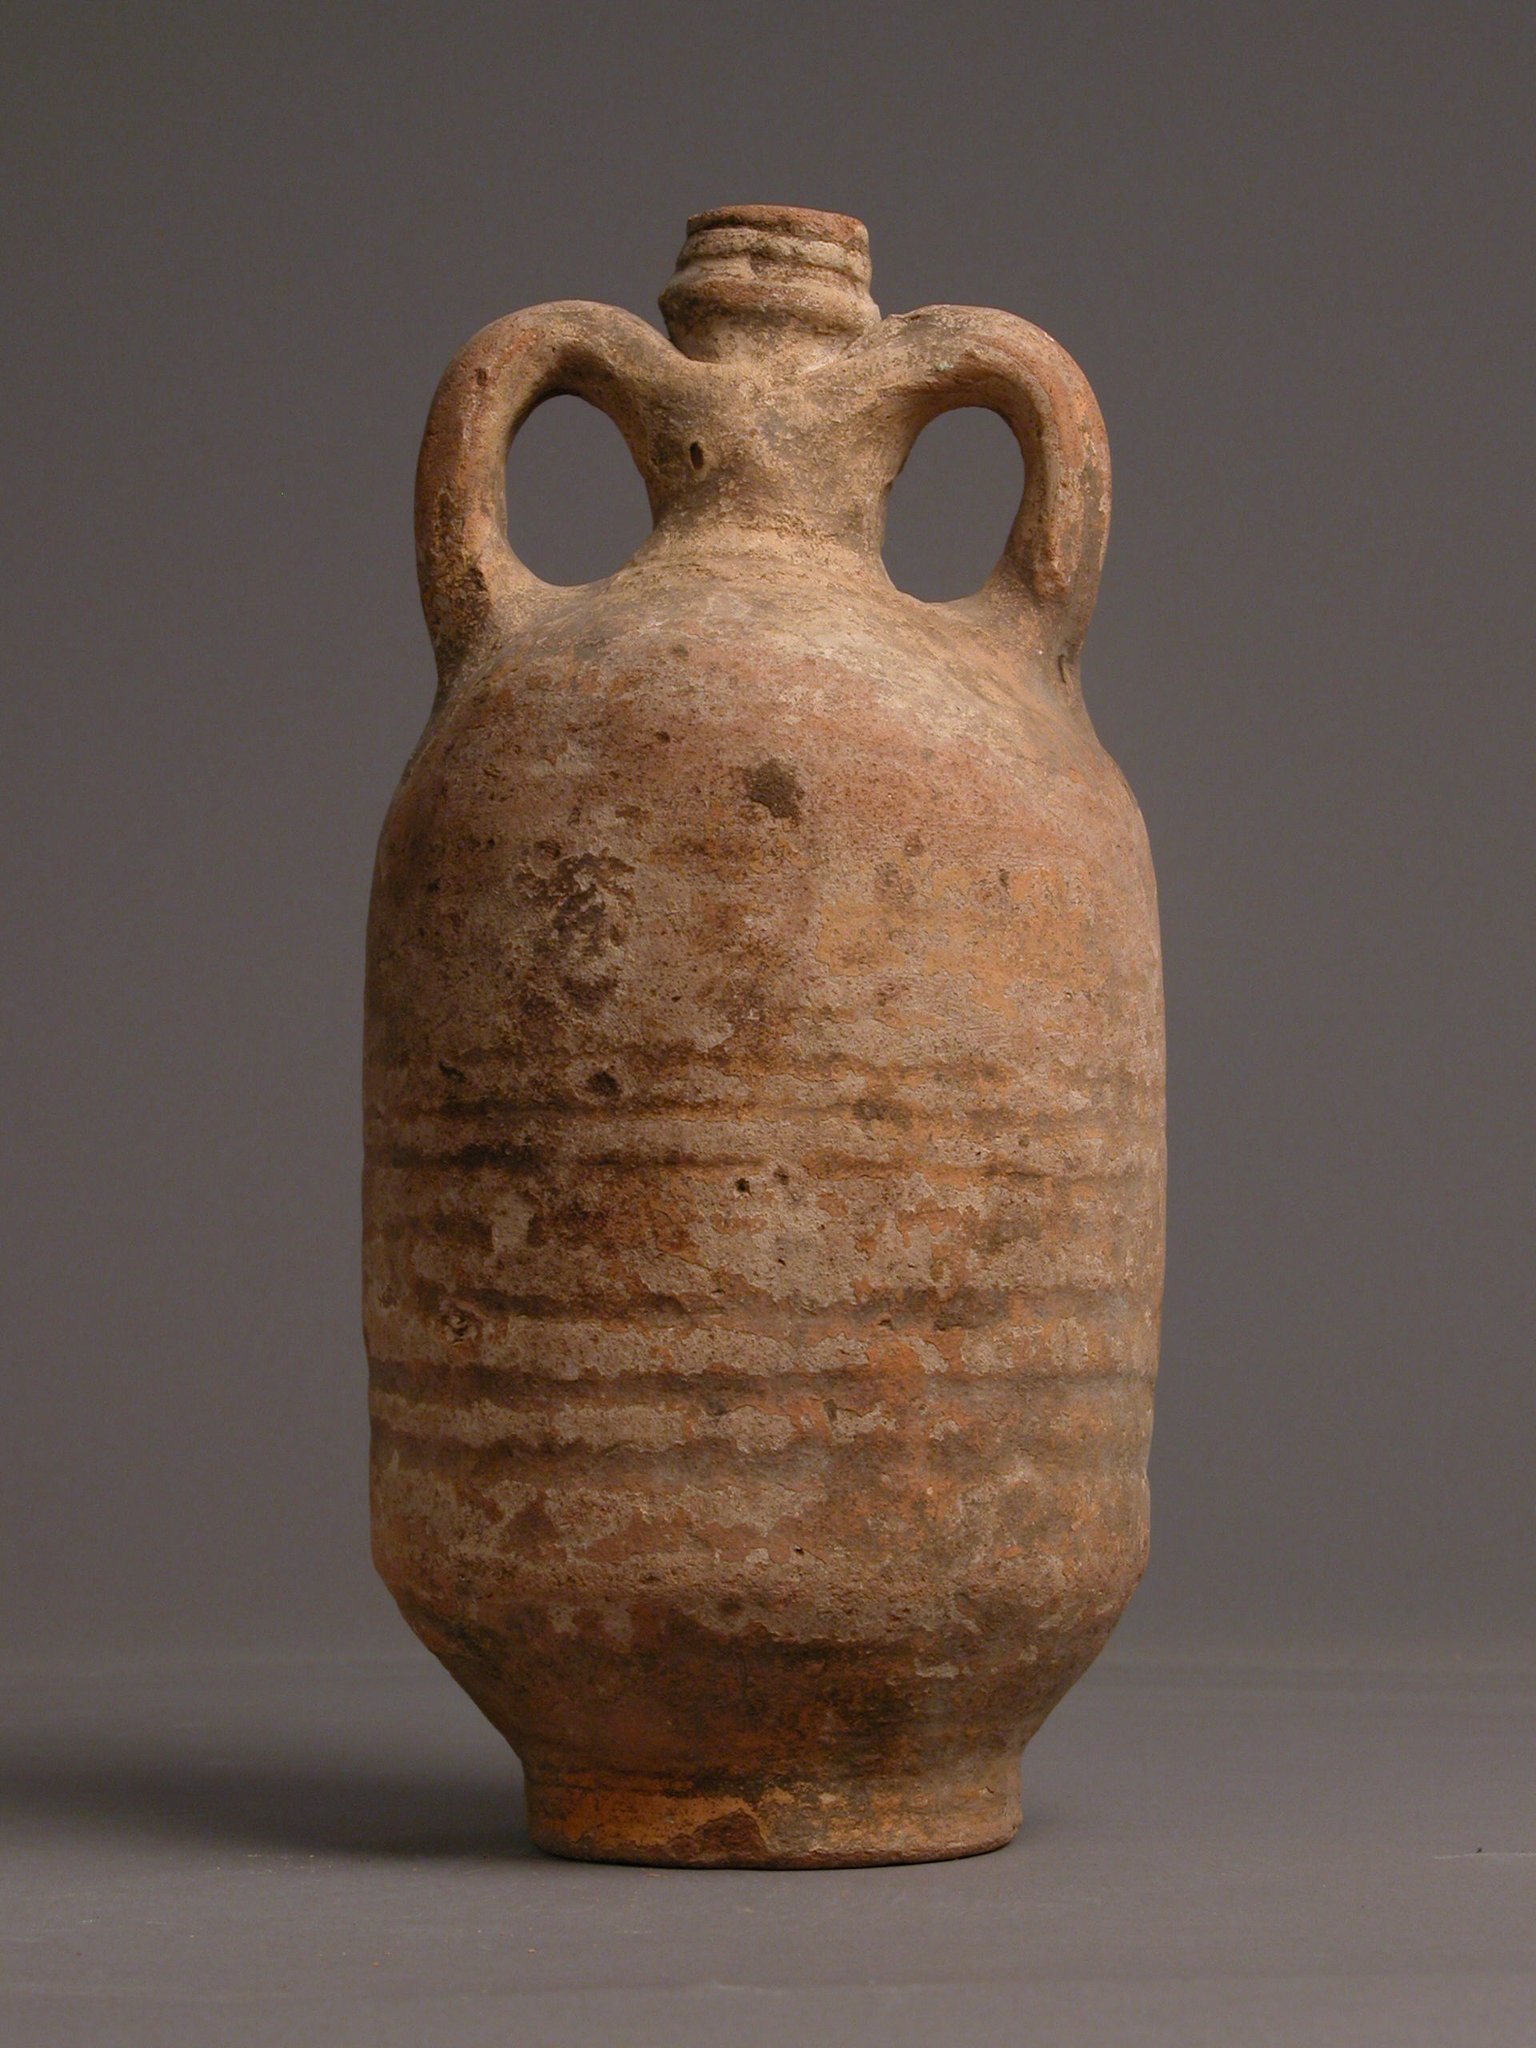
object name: jug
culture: coptic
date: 301-700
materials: earthenware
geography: egypt